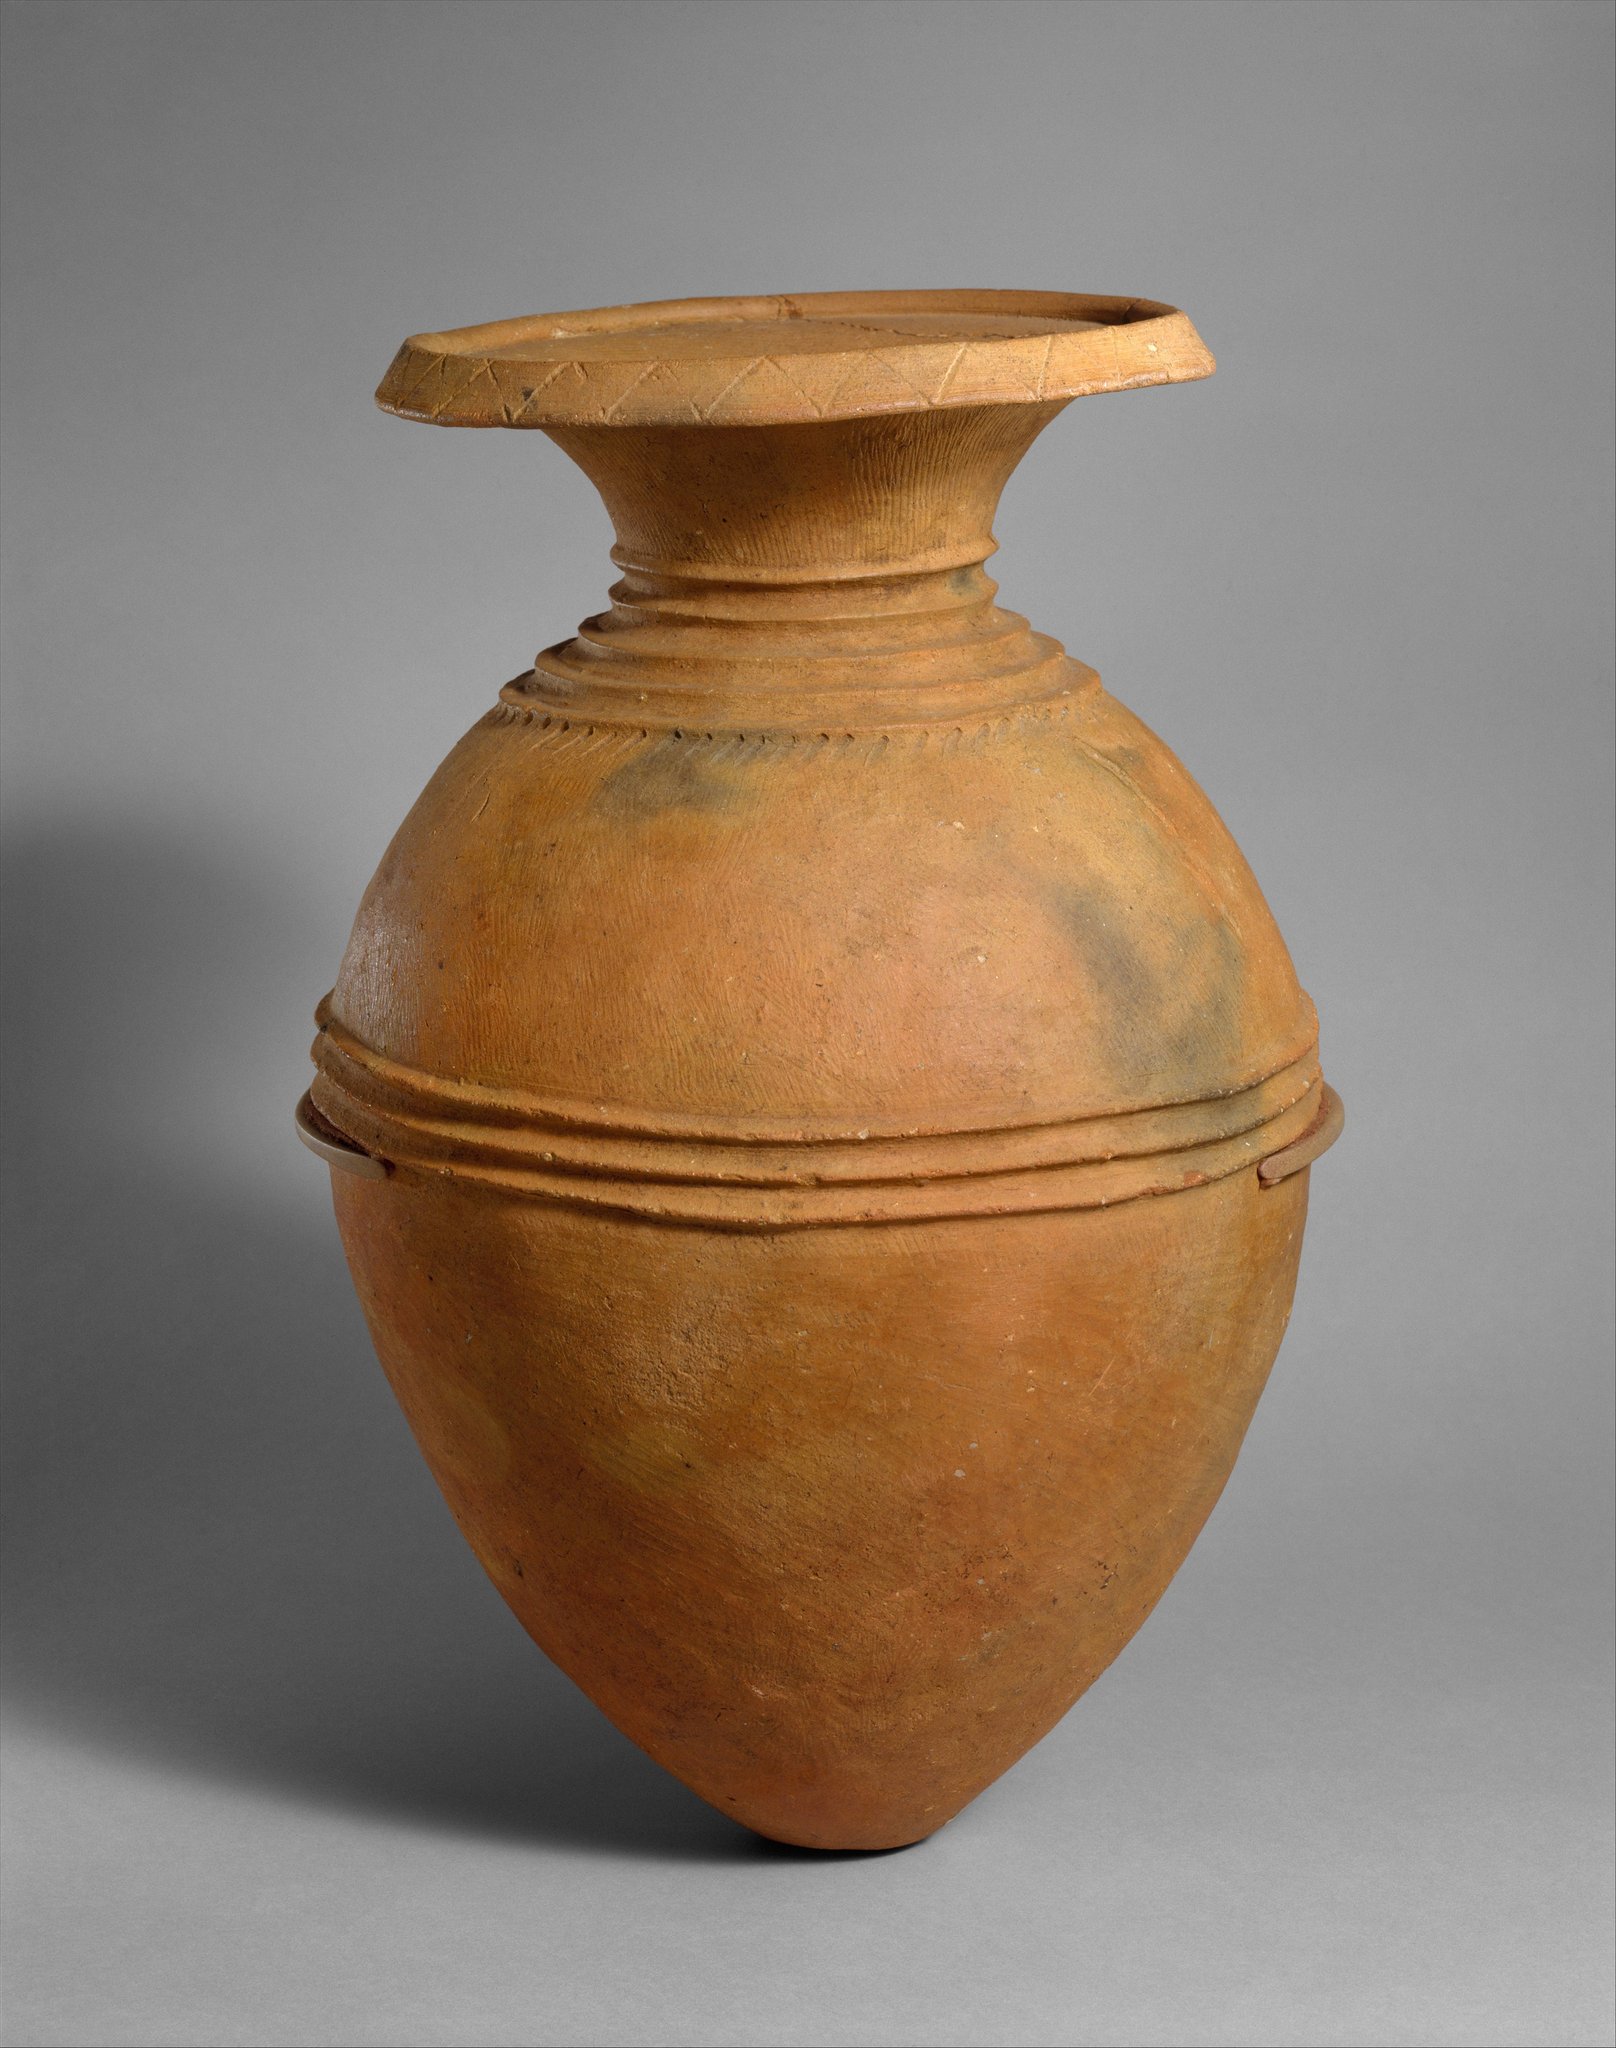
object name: storage jar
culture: japanese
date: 100 BCE-100 CE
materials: earthenware